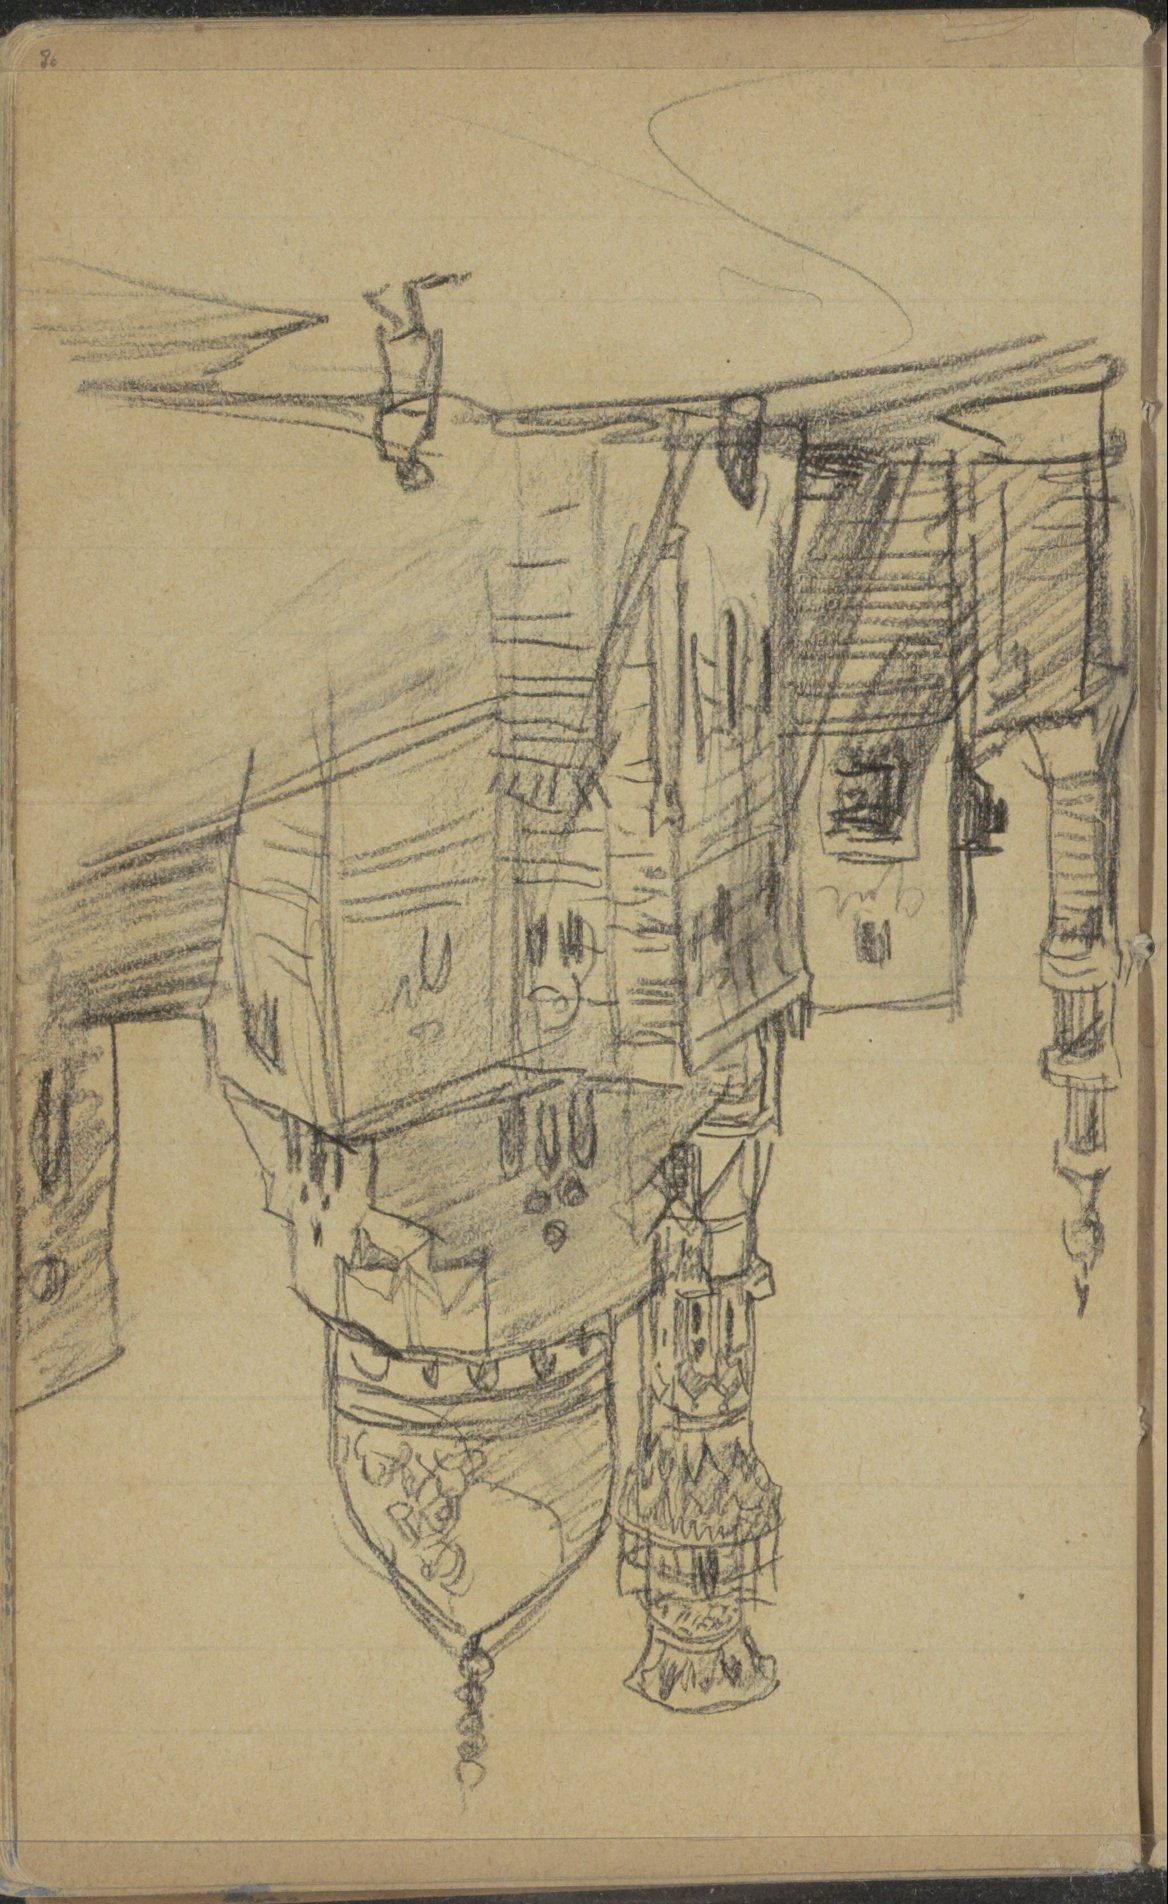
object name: sketchbook leaf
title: Straat met een moskee in Caïro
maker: marius bauer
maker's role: draughtsman, print maker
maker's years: 1867-1932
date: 1894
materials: chalk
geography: cairo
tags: temple, shrine ~ islam, mohammedanism, street (+ city(-scape) with figures, staffage)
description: Mogelijk de Kait Bey moskee. Pagina 86 uit een schetsboek met 48 bladen.